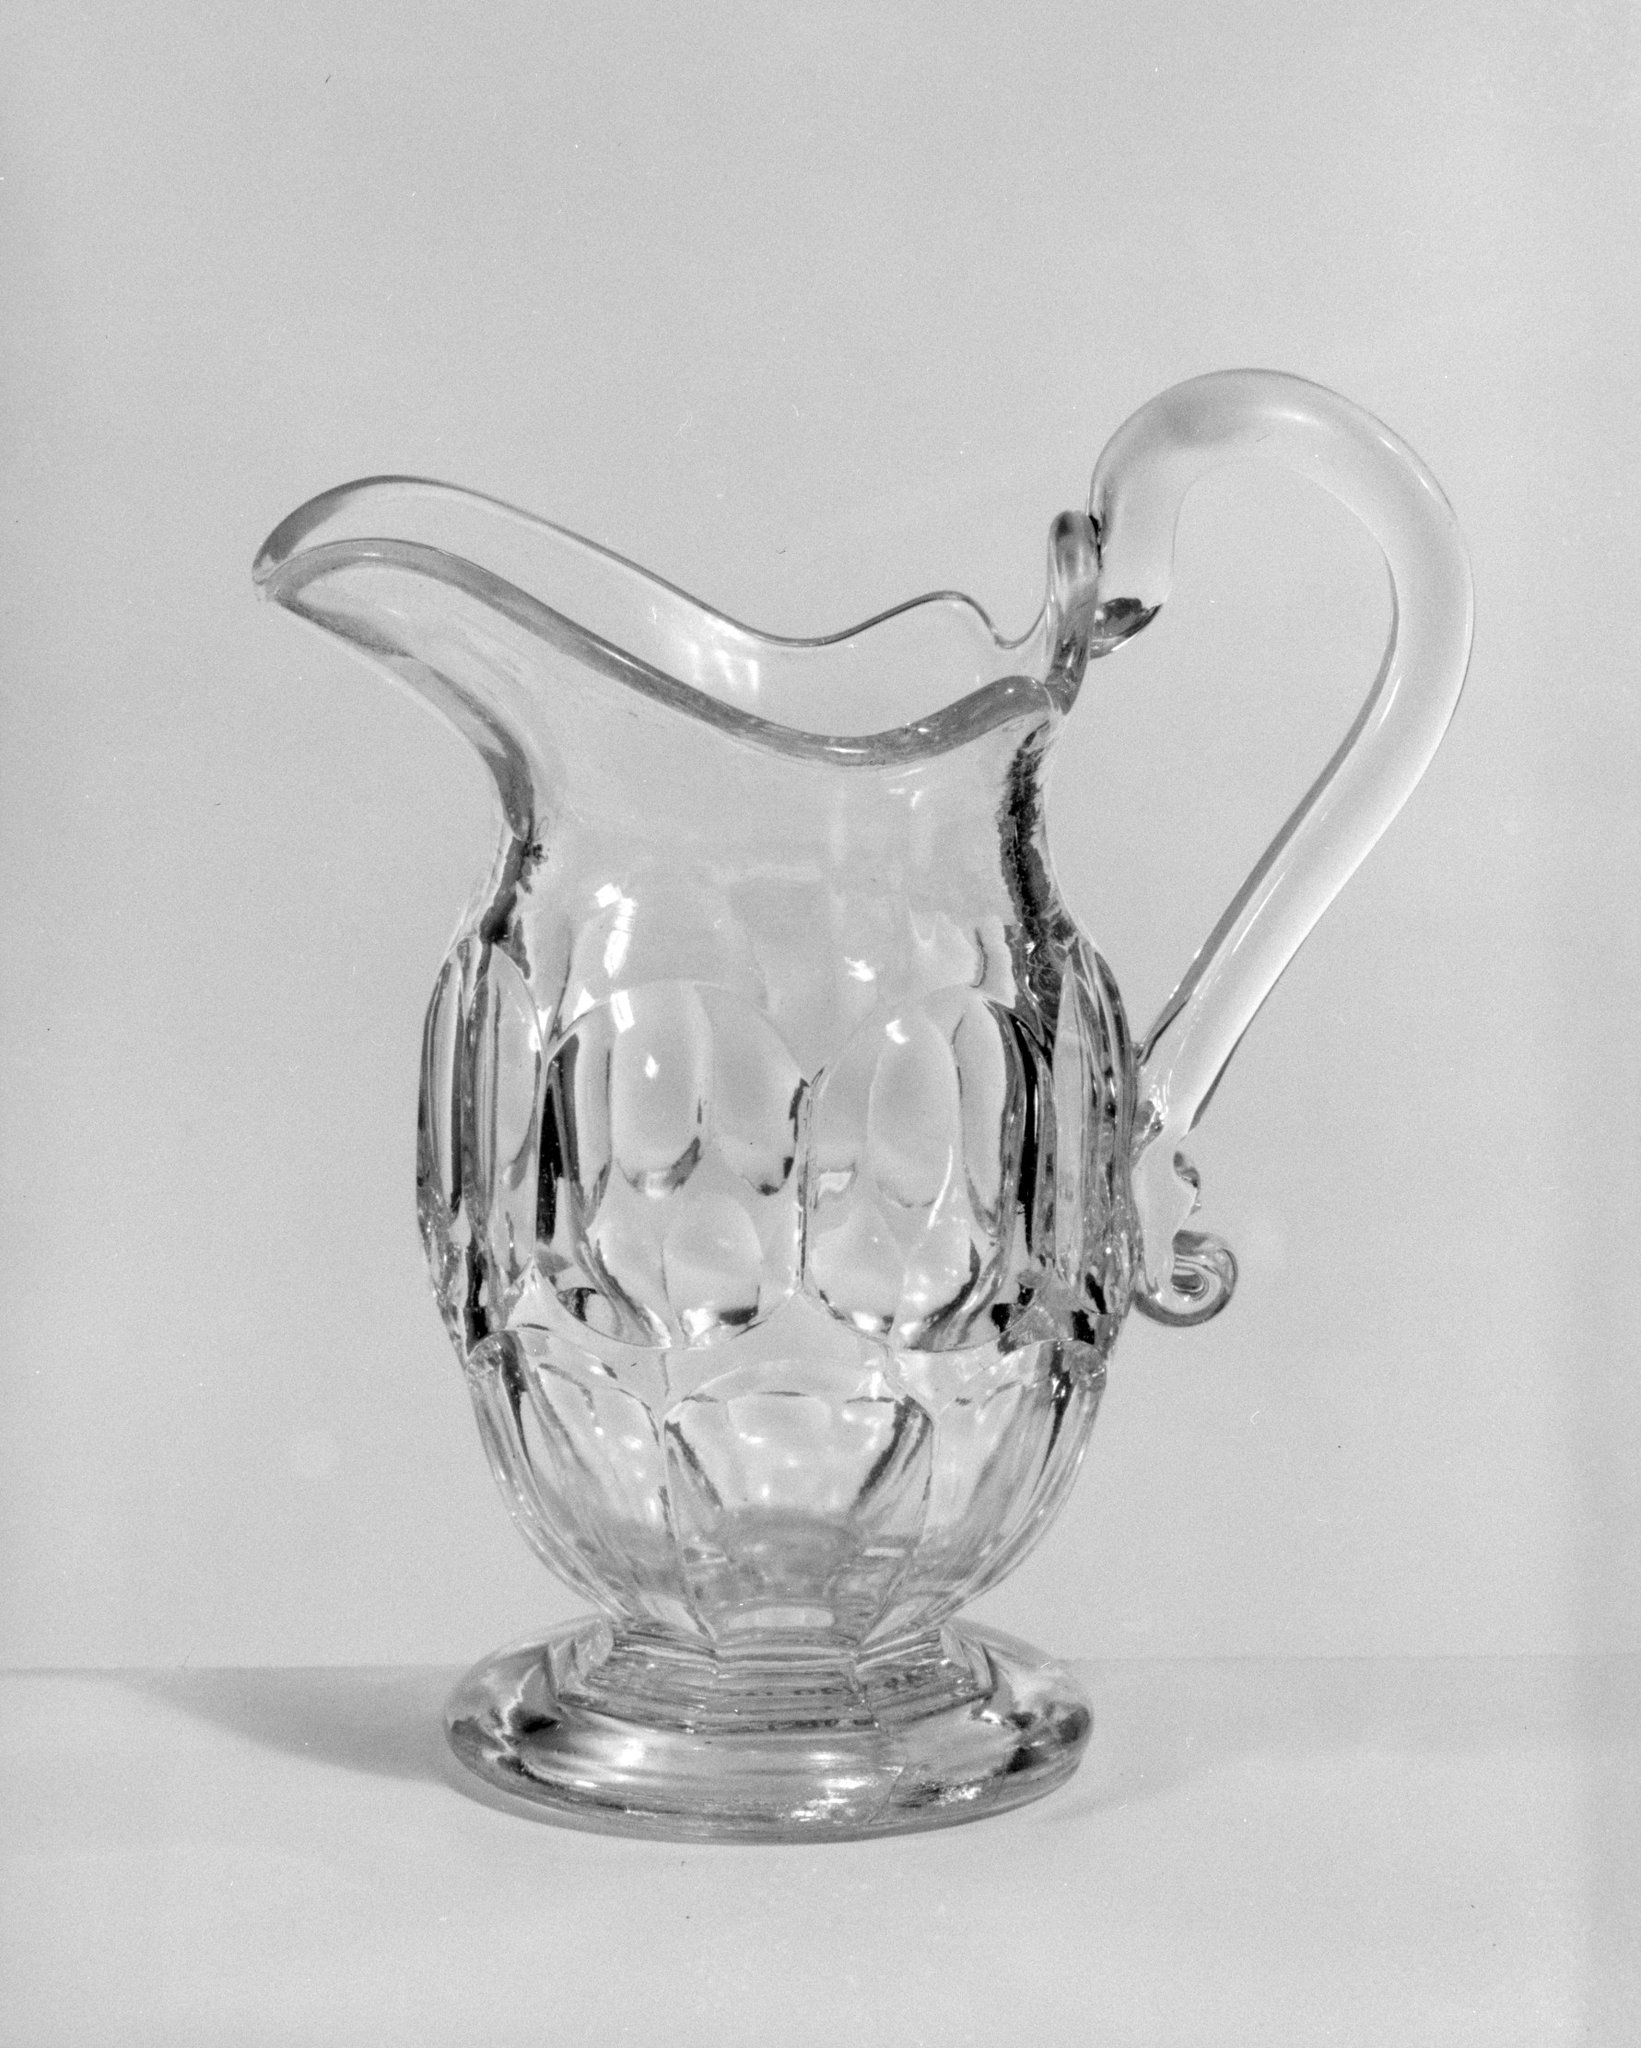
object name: cream pot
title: Creamer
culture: american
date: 1830-1870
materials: glass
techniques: pressed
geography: united states